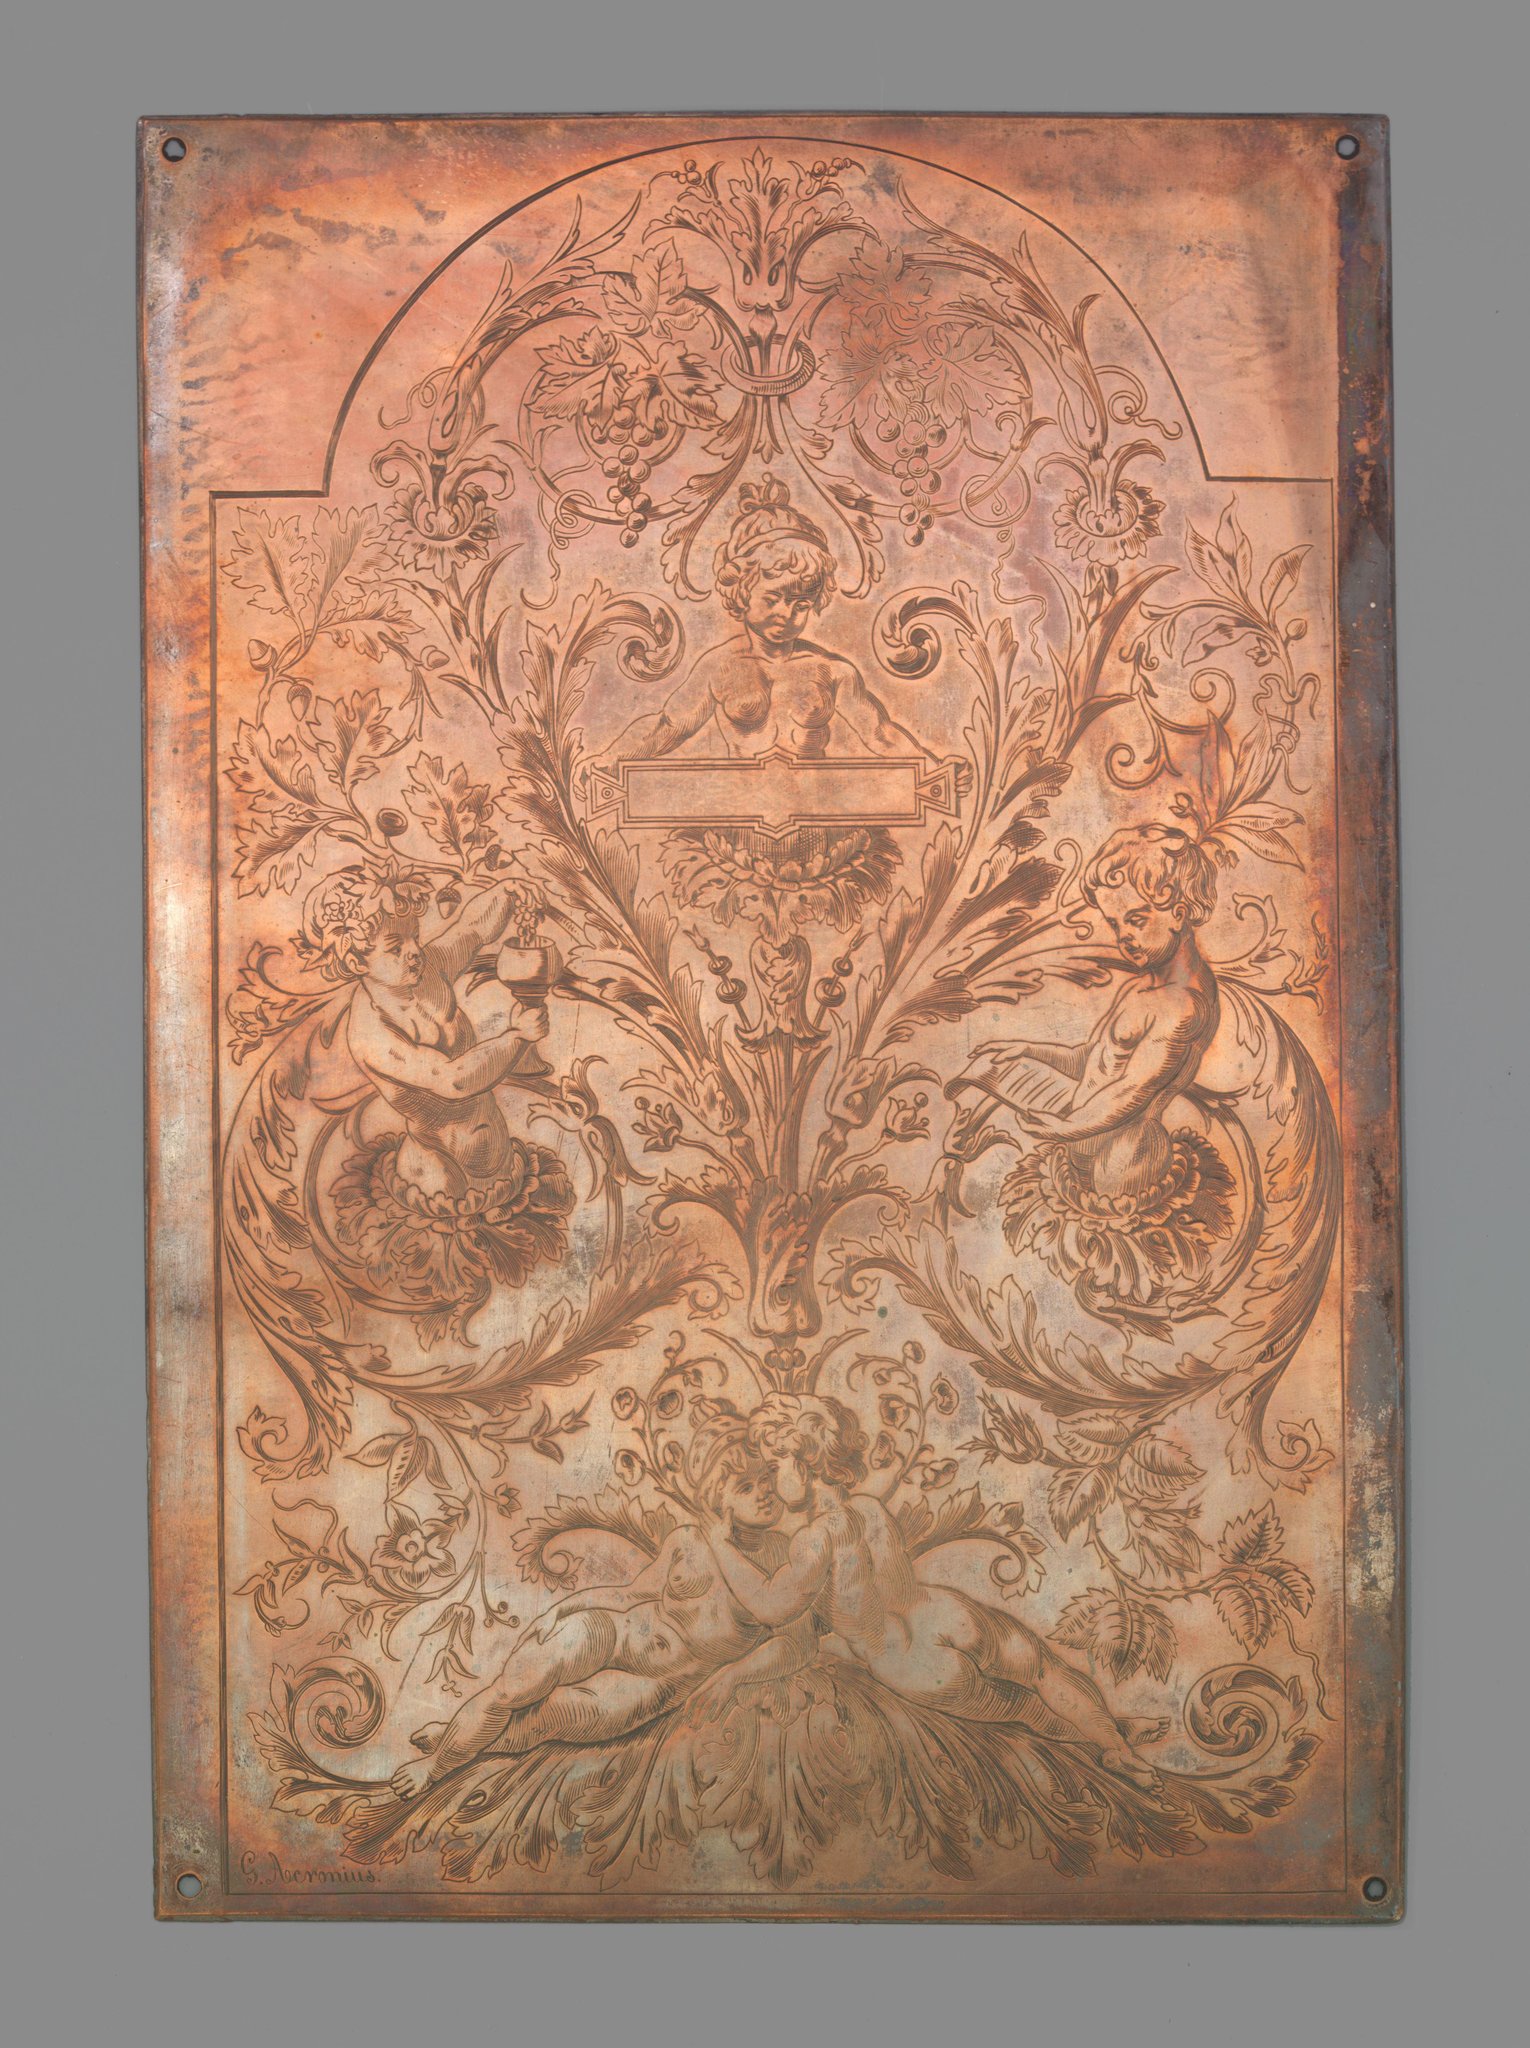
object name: copper plate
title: Ornament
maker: g. acronius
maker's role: print maker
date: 1900-1930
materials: copper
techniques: engraving